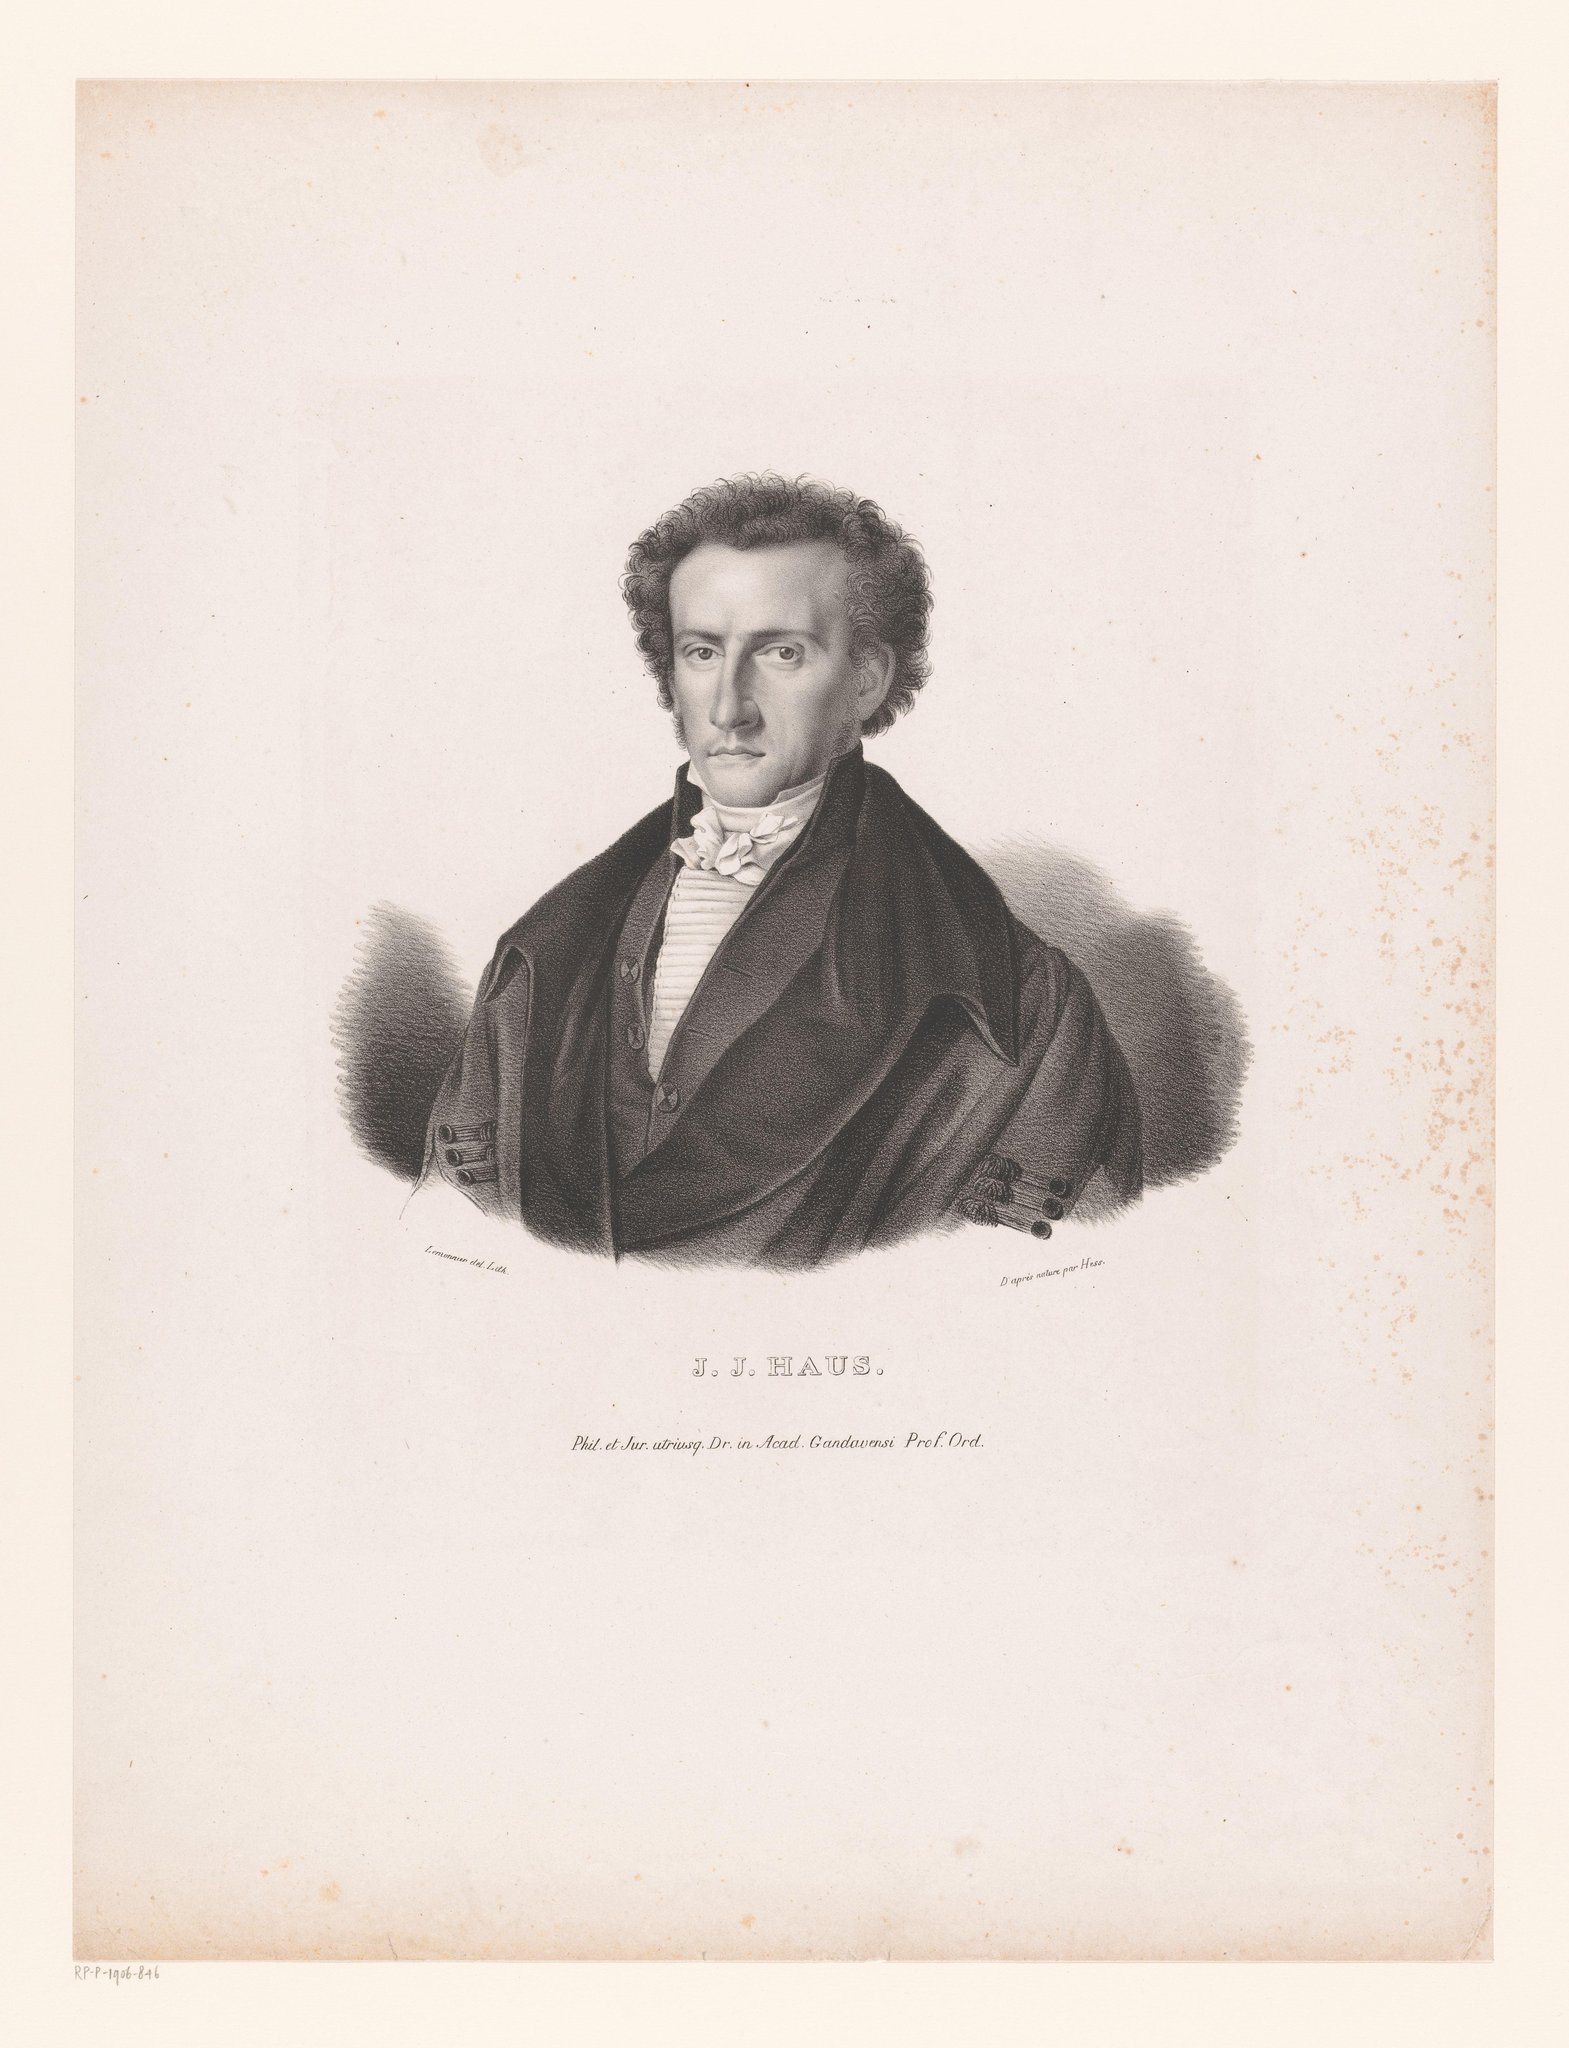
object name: print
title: Portret van Jacques-Joseph Haus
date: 1827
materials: paper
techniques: lithograph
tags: ghent, historical persons, professor (+ portrait of teacher, professor)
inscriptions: collector's mark: Lugt 2228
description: Prent verschenen in: Hess, Marcel. Iconographie des professeurs des universites des Pays-Bas. Brussel: Van Someren, 1827.